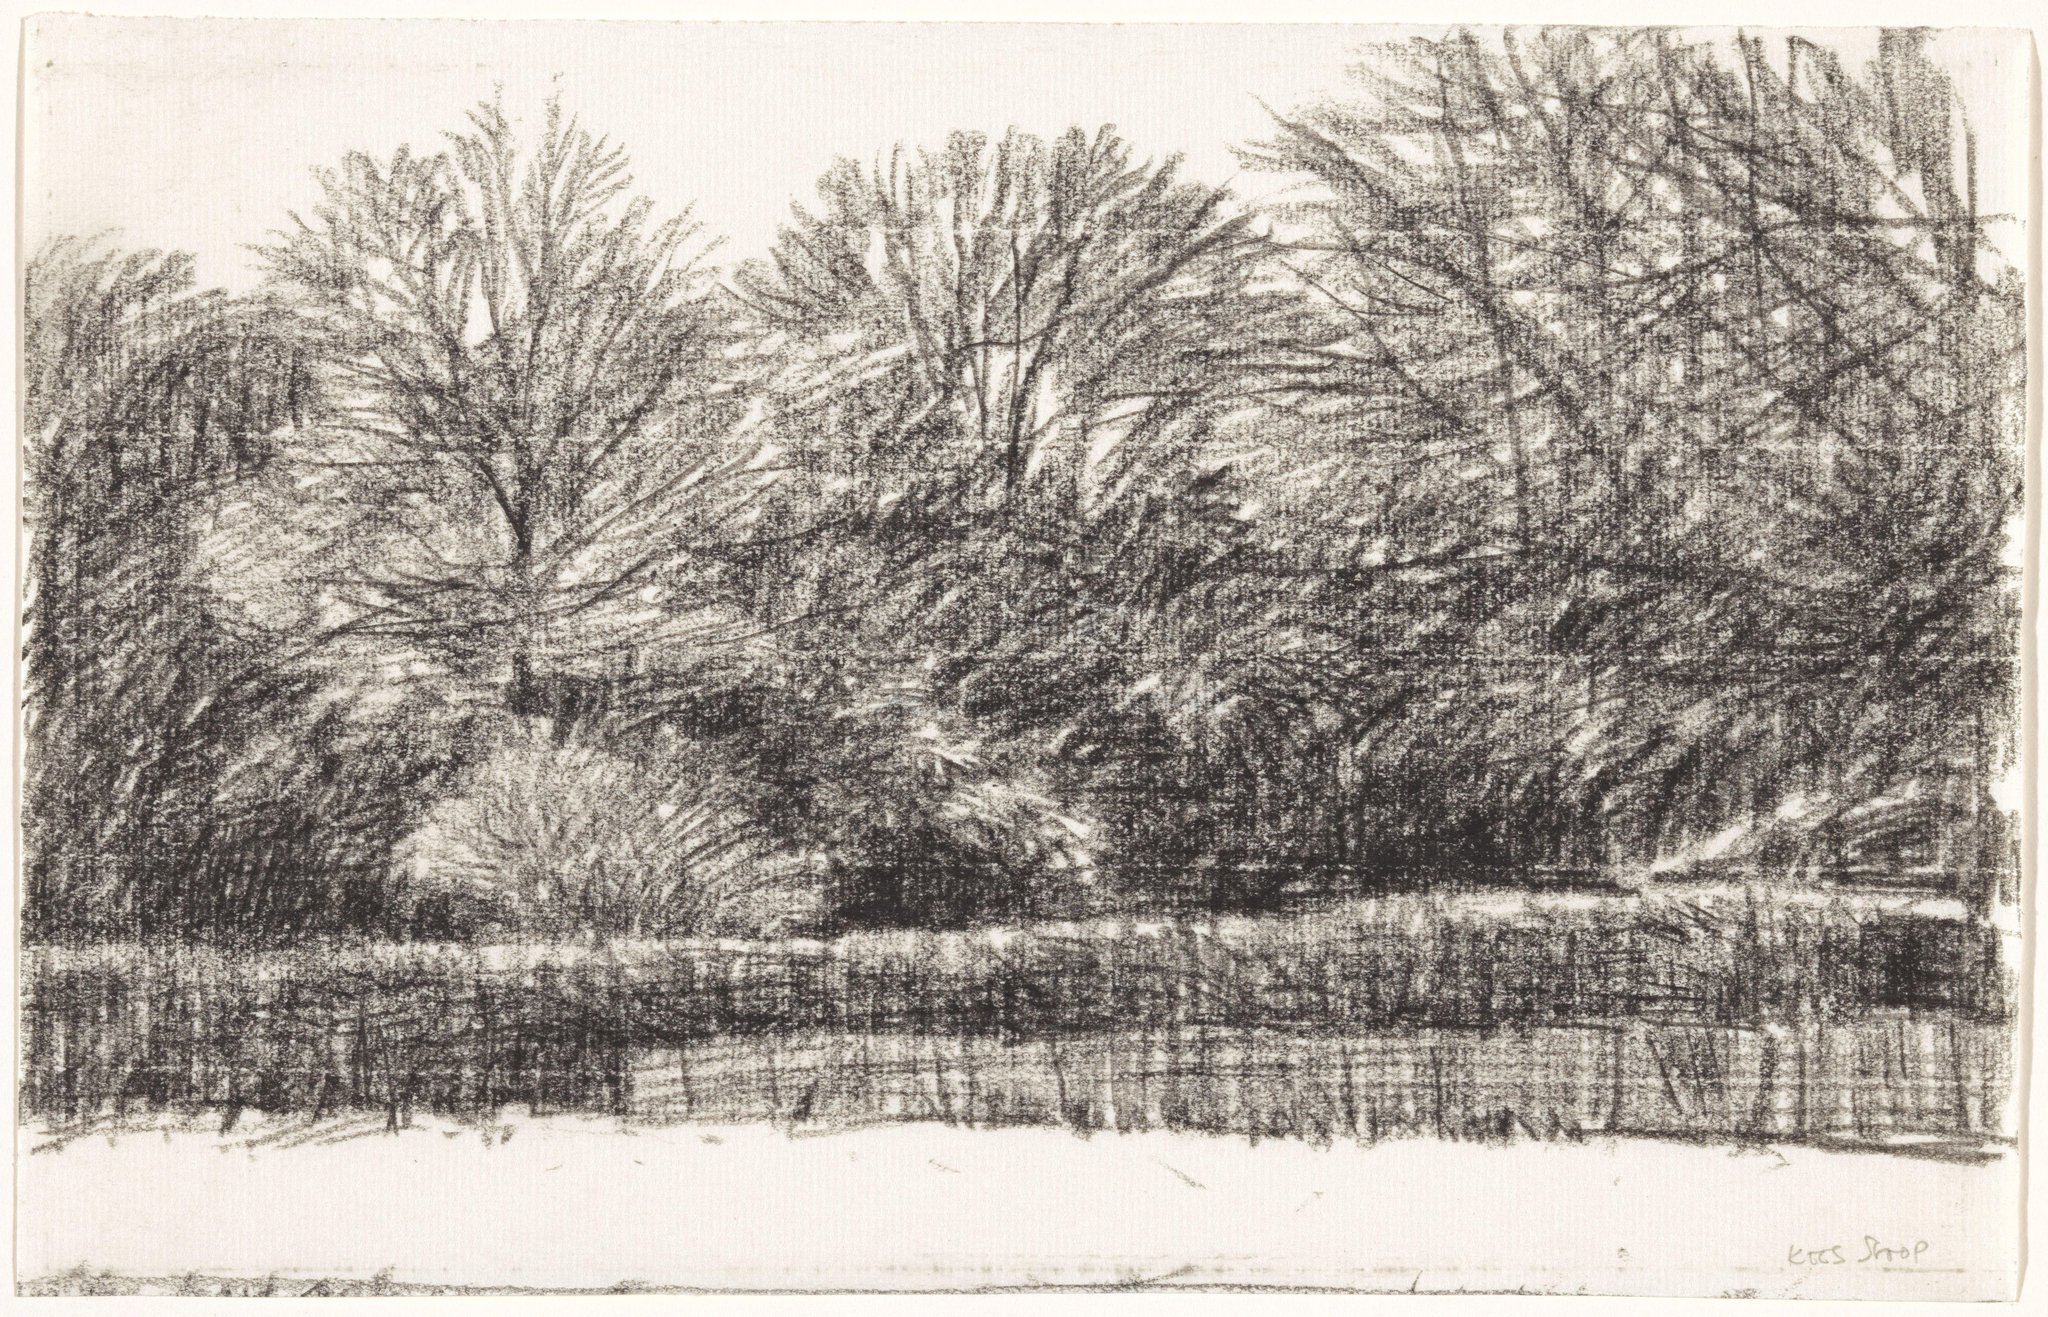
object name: drawing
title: Boomrand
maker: kees stoop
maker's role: draughtsman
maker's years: 1929-2019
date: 1939-2009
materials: charcoal, paper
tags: groups of trees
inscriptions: signature: ‘KEES STOOP’